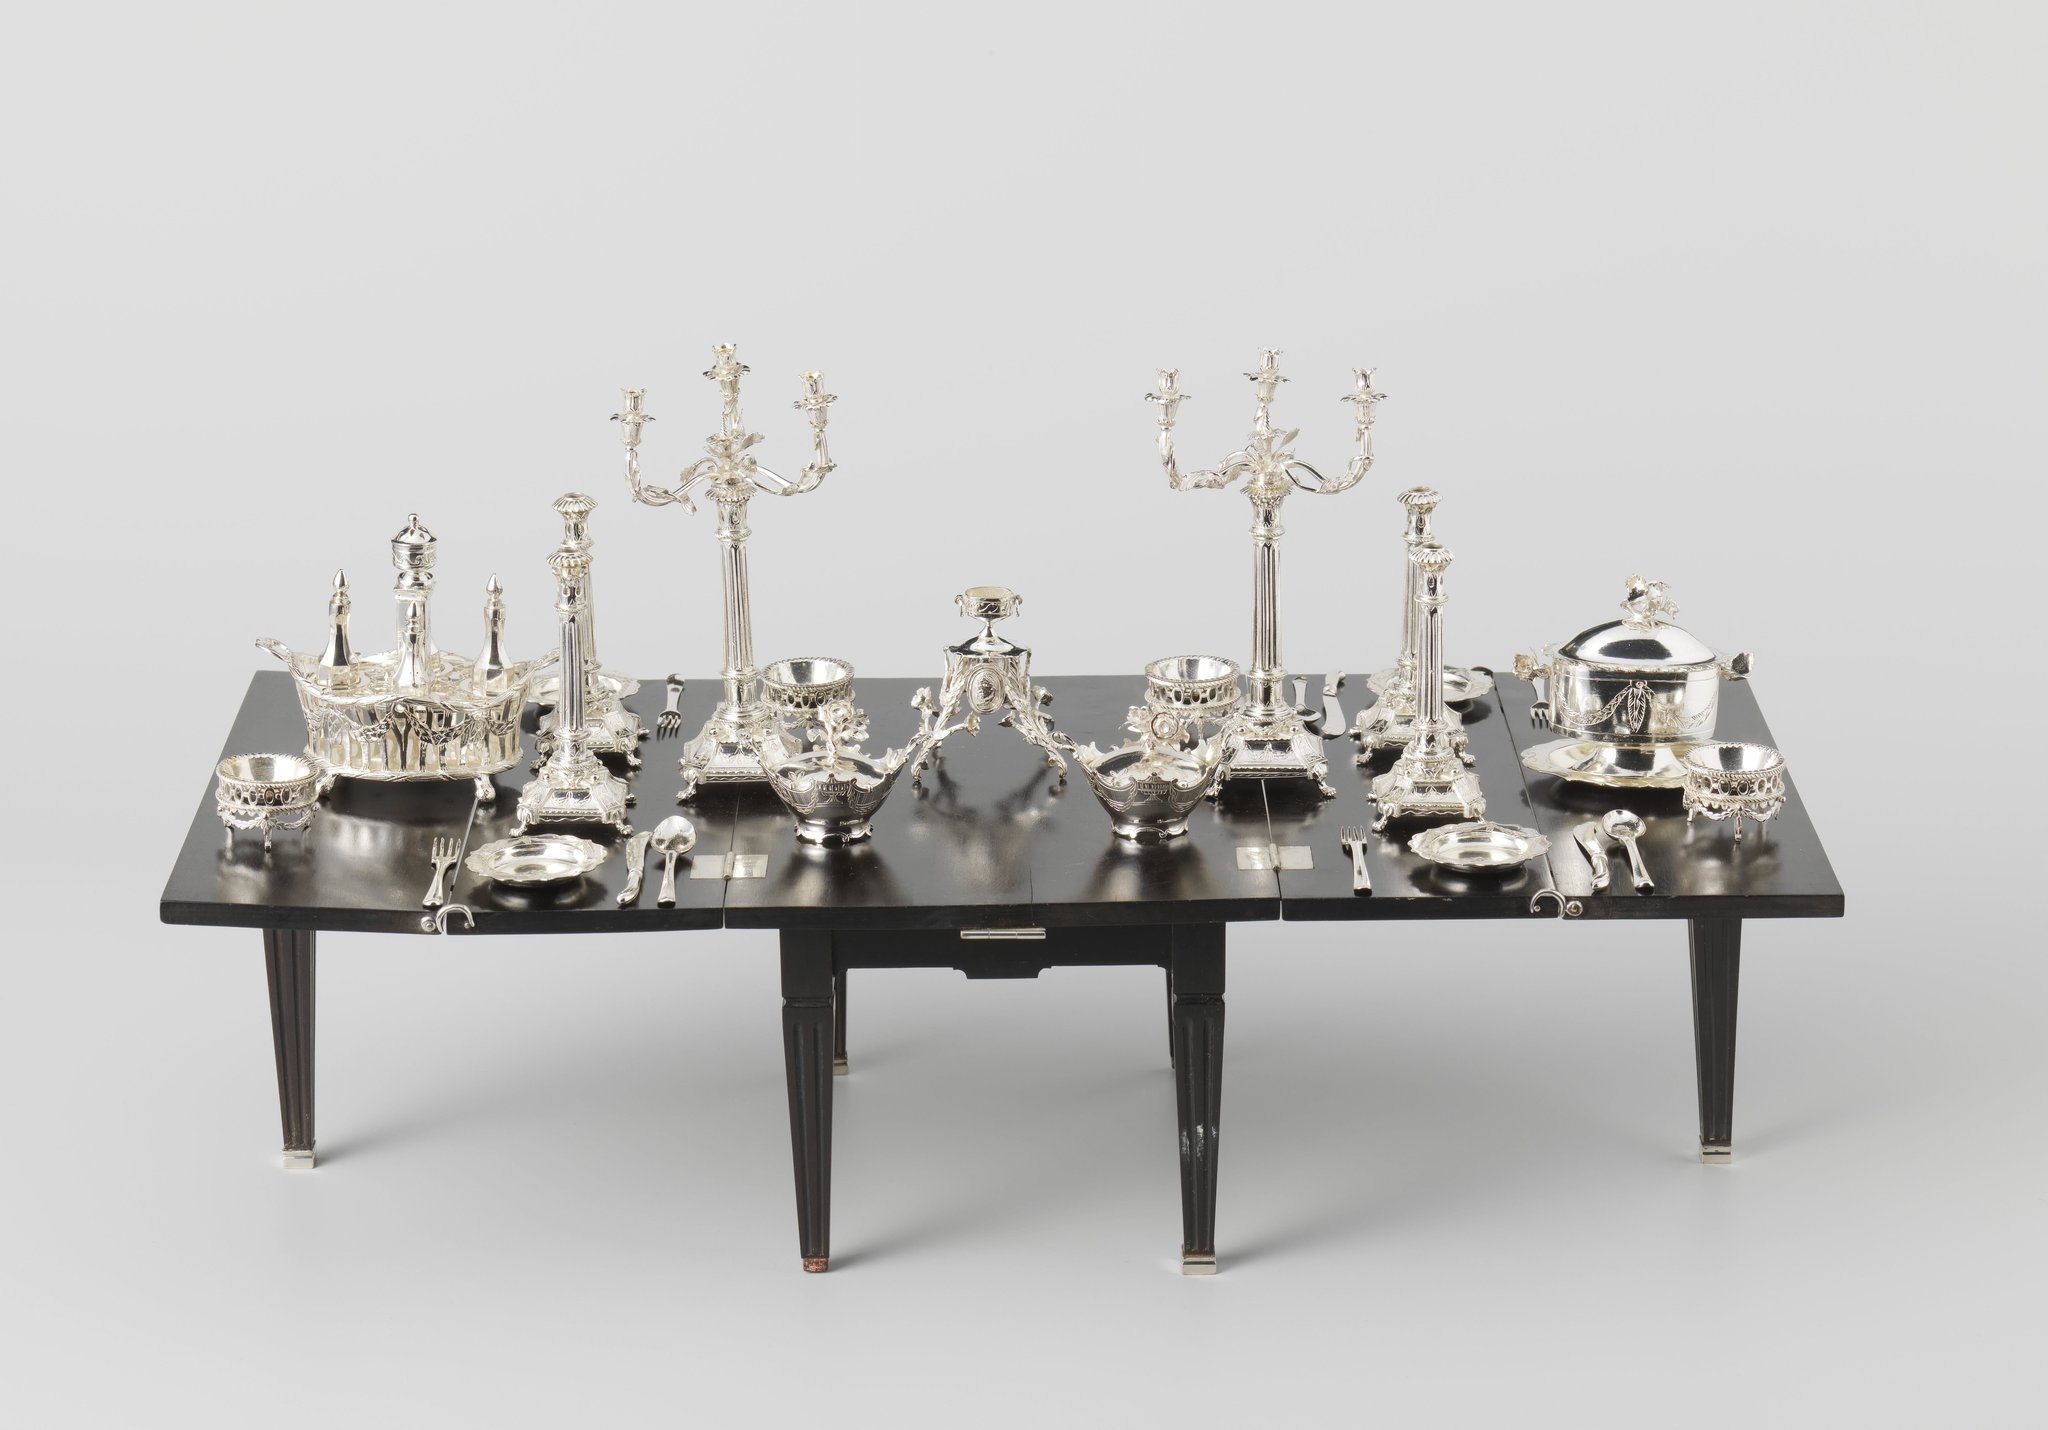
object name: miniature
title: Lepel met dubbel lof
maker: Anonymous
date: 1790-1800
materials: silver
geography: netherlands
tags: spoon